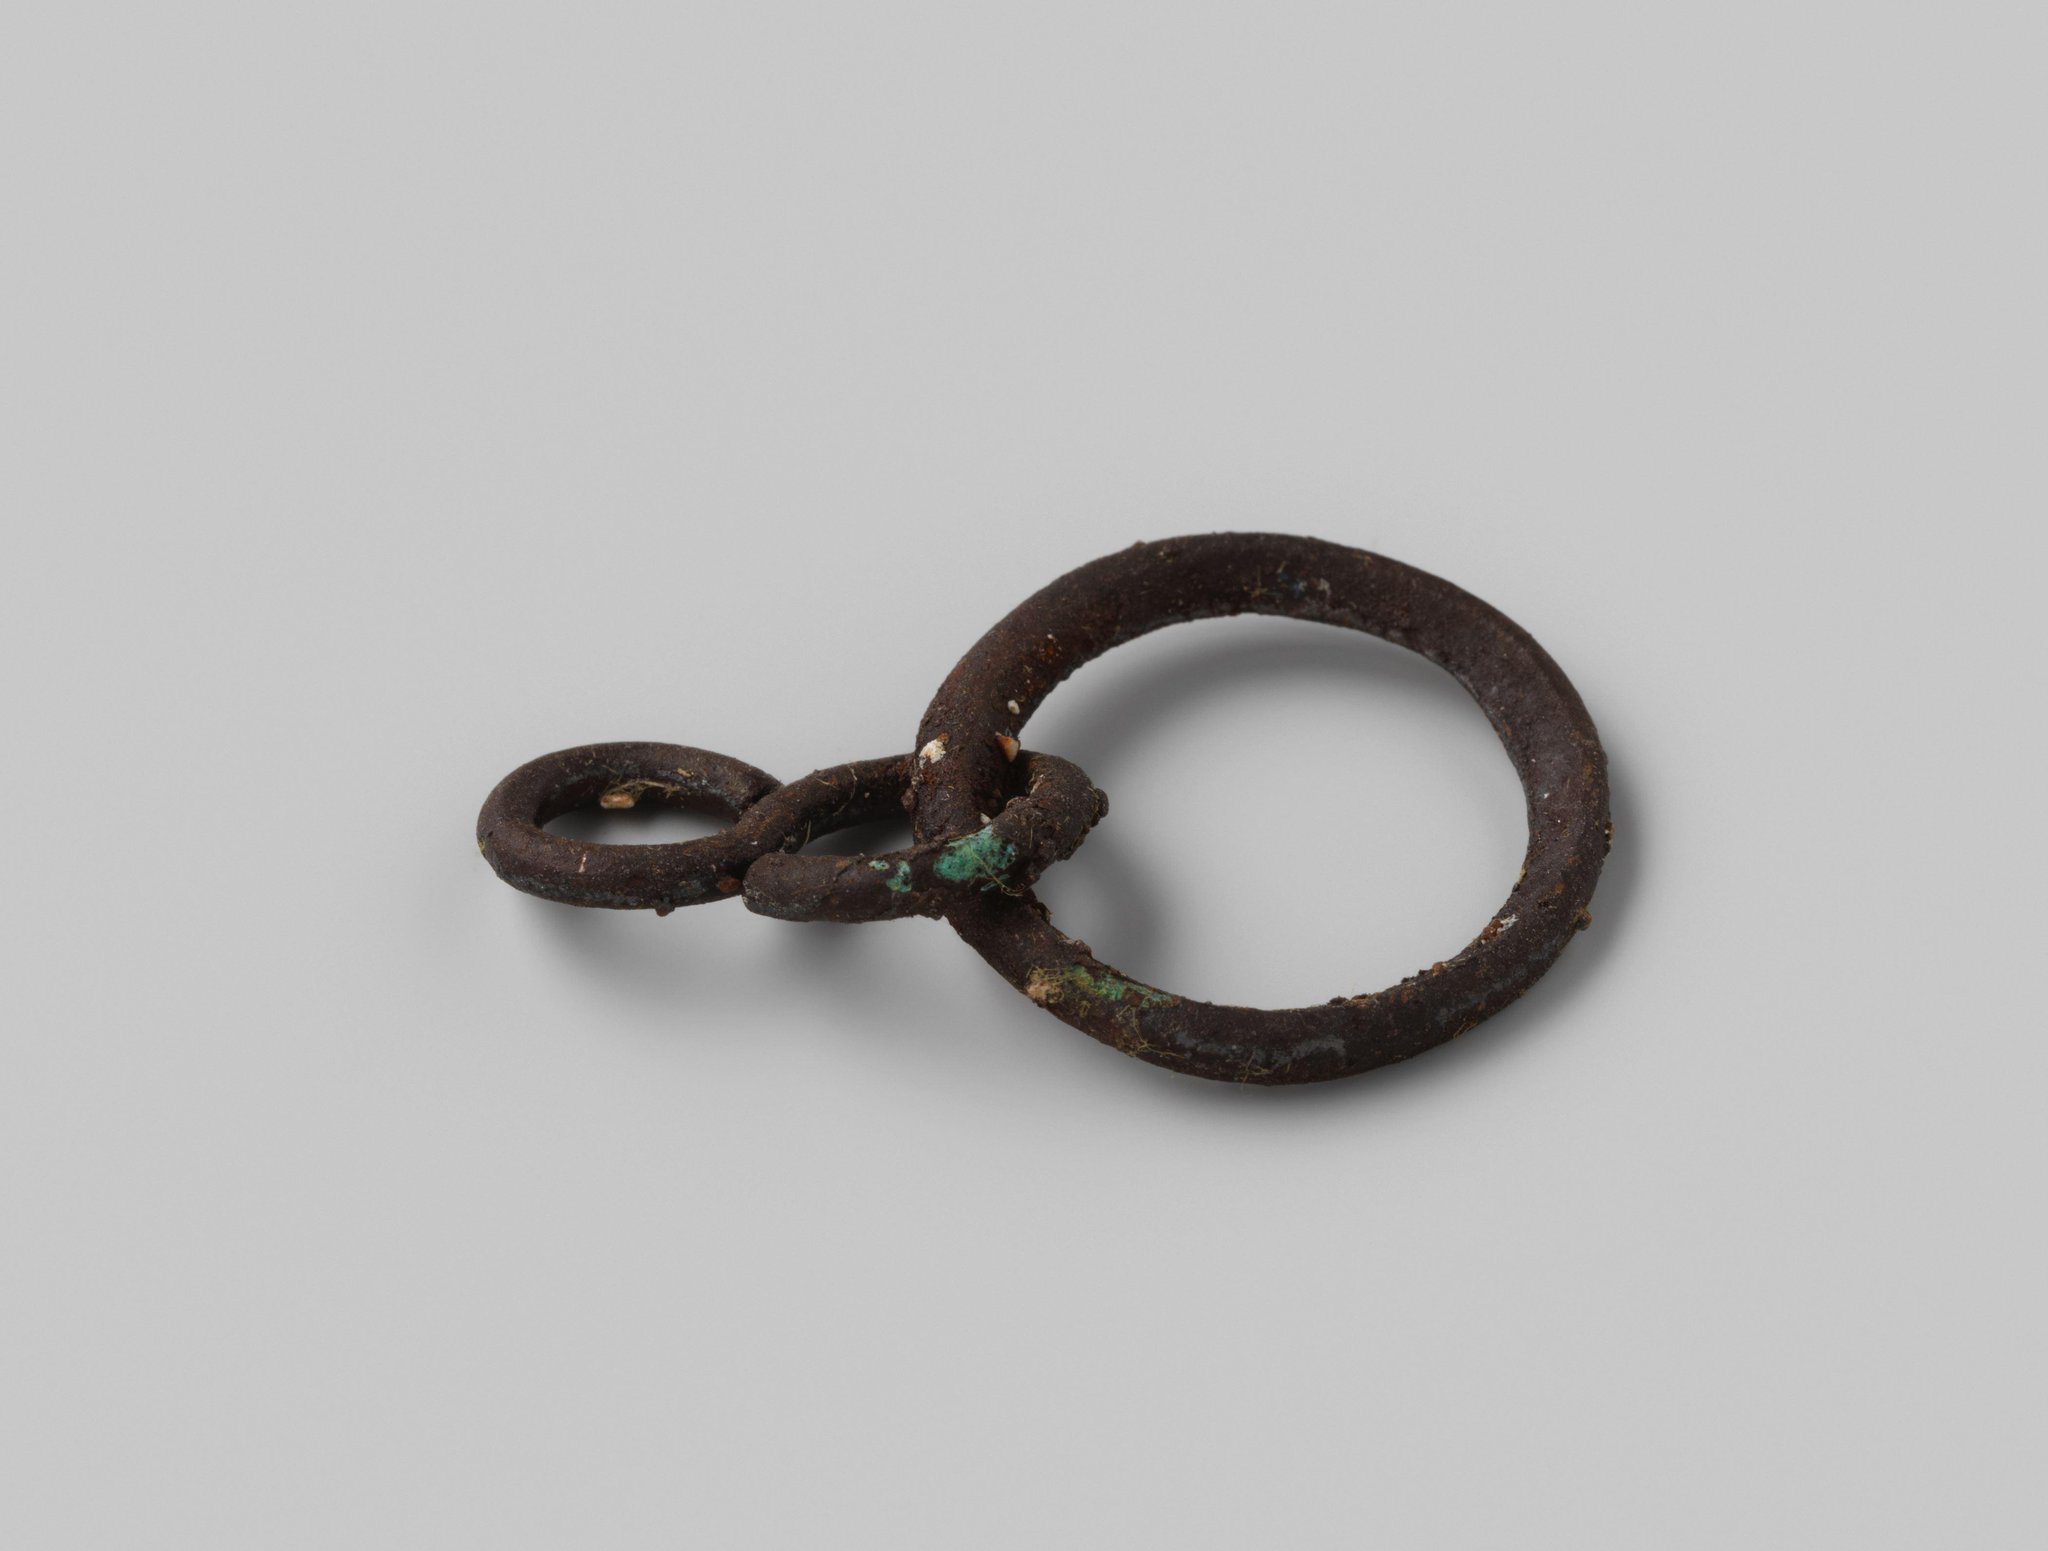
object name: fragment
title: Ringvormig fragment met schakels uit het wrak van de Oost-Indiëvaarder Hollandia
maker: Anonymous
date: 1700-1743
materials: copper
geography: netherlands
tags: verenigde oostindische compagnie, hollandia (schip), annet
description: Varied parts or fragments, rings or ring-shaped fragments; circular, circular in section, with fragm of chain.